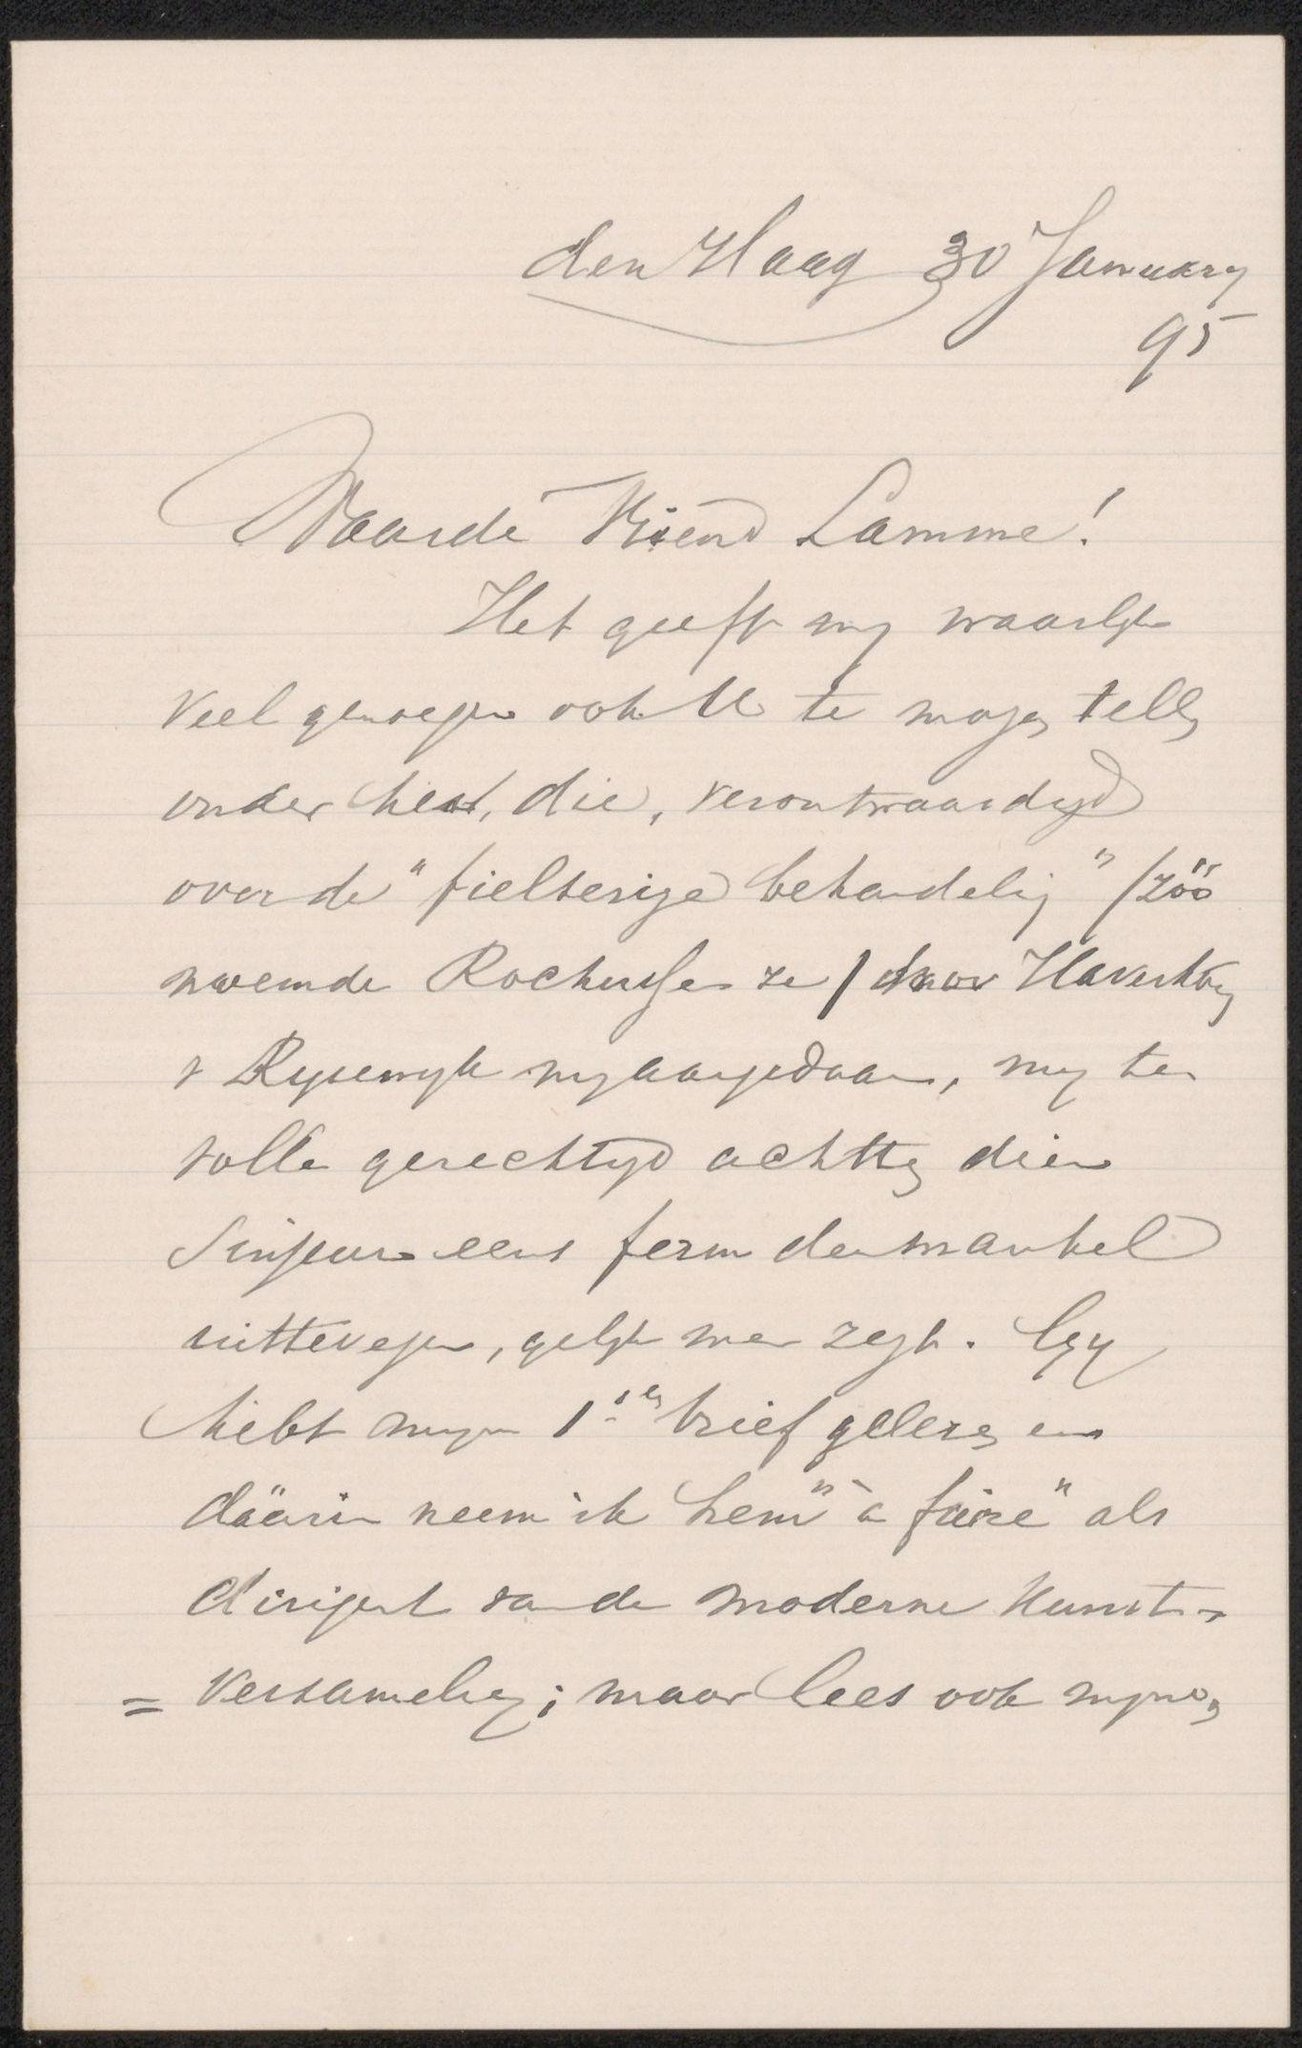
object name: letter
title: Brief aan Ary Johannes Lamme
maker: david bles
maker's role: draughtsman, painter, print maker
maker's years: 1821-1899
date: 1895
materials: ink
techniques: pen, writing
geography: the hague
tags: rotterdam, painter, charles rochussen, dordrecht, print maker, draughtsman, ary johannes lamme, pieter haverkorn van rijsewijk, criticizing and discussing art, art criticism, painting (including book-illumination, miniature-painting)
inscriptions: collector's mark: Lugt 2228